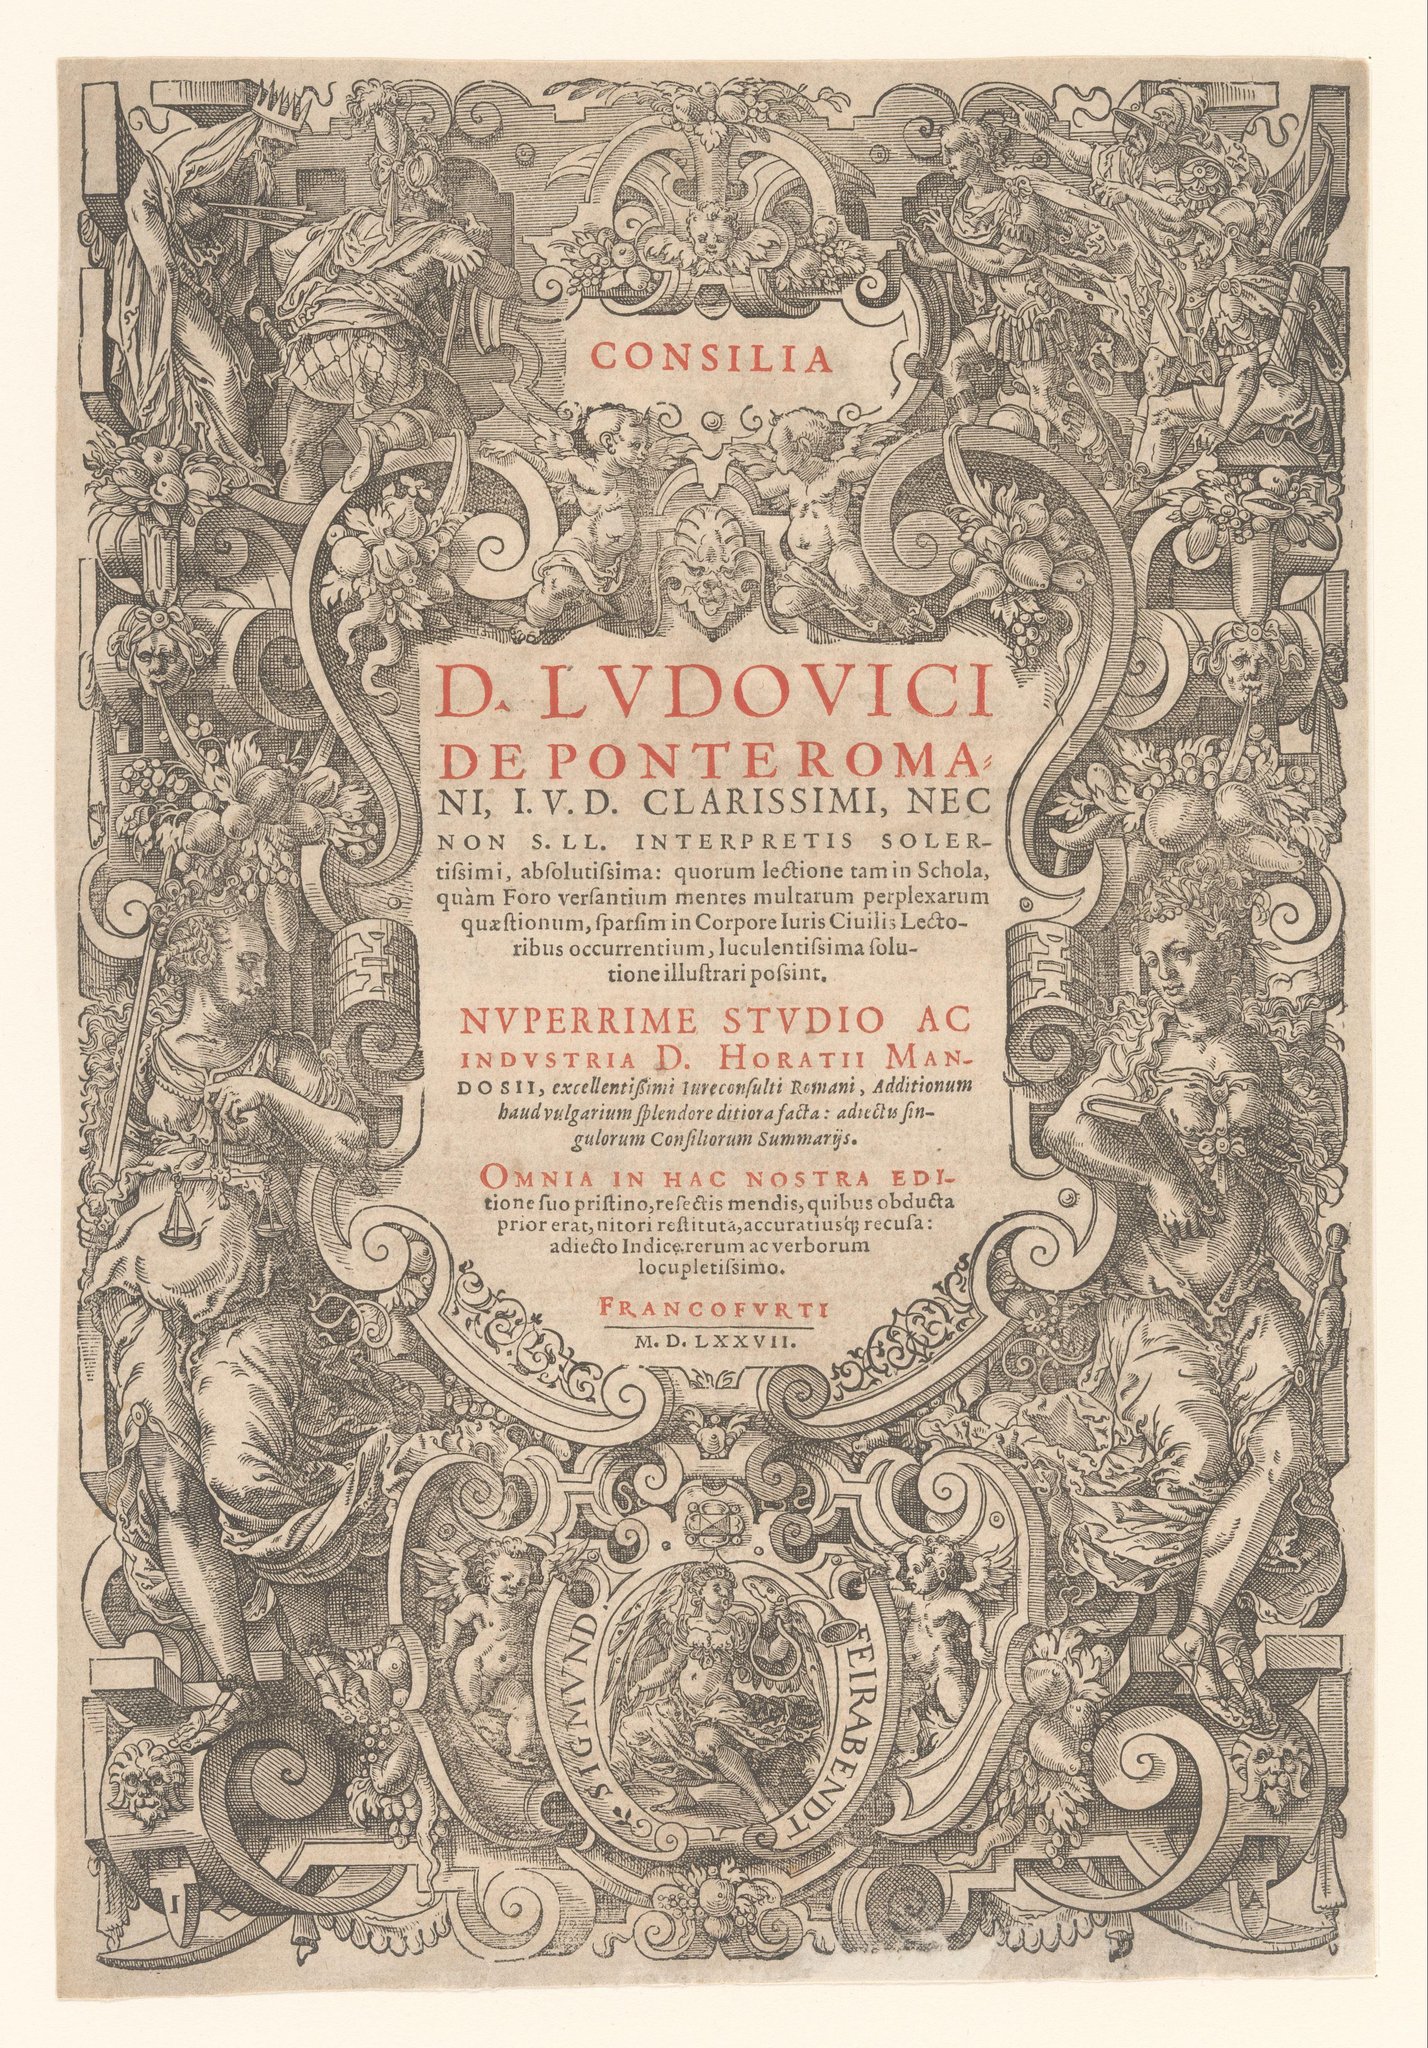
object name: print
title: Titelpagina voor: Ludovico Pontano, Consilia D. Ludovici de Ponte Romani (...), 1577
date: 1577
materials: paper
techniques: letterpress printing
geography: frankfurt am main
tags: archer's weapons: bow and arrow, fruits and vegetables ~ ornament, violent death by arrow(s), justitia (justice) as roman personification, device (trade-mark of printer or publisher), fame; 'fama', 'fama buona', 'fama chiara' (ripa), cupids: 'amores', 'amoretti', 'putti'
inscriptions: collector's mark: Lugt 2228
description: Titelpagina voor: Pontano, Lodovico. Consilia D. Ludovici de Ponte Romani (...). Frankfurt: Sigmund Feyerabend, 1577. De omlijsting werd in ieder geval eerder gebruikt voor een publicatie uit 1574, en later nog in 1580.